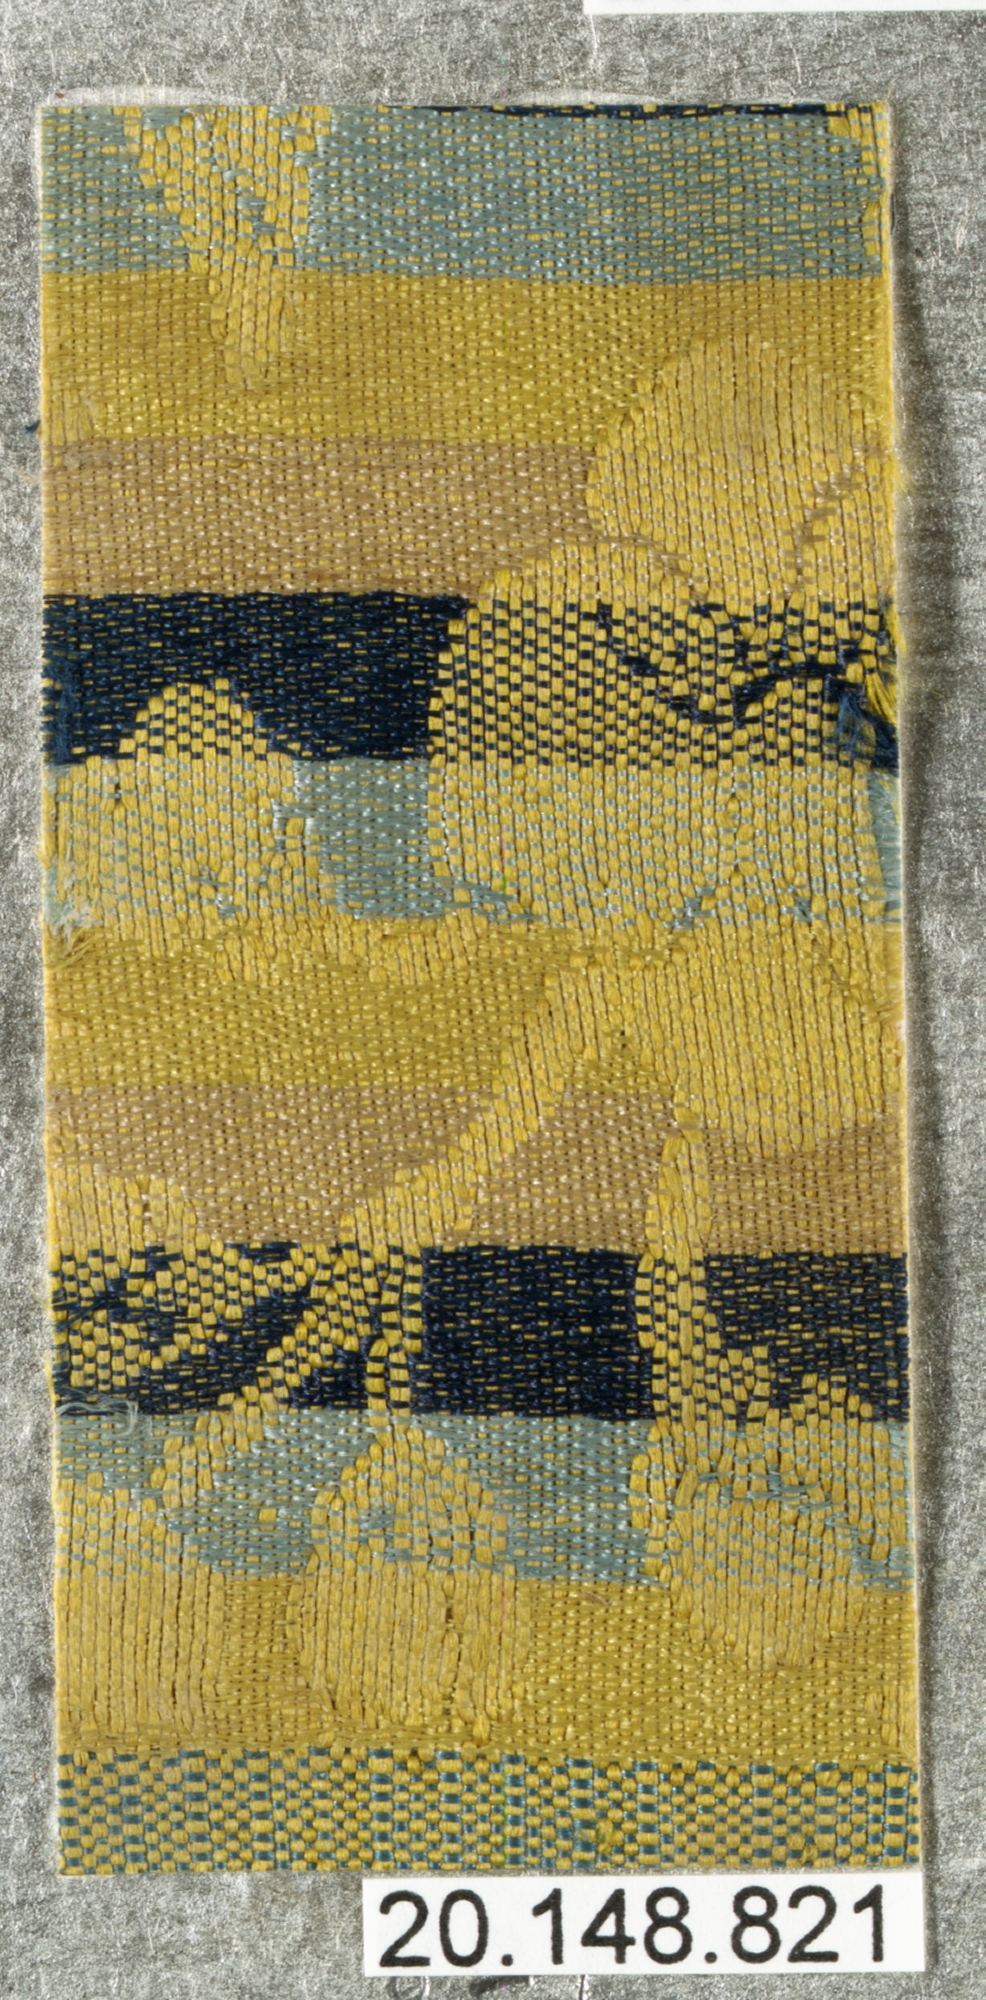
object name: piece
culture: japanese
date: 1701-1800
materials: silk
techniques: compound weave